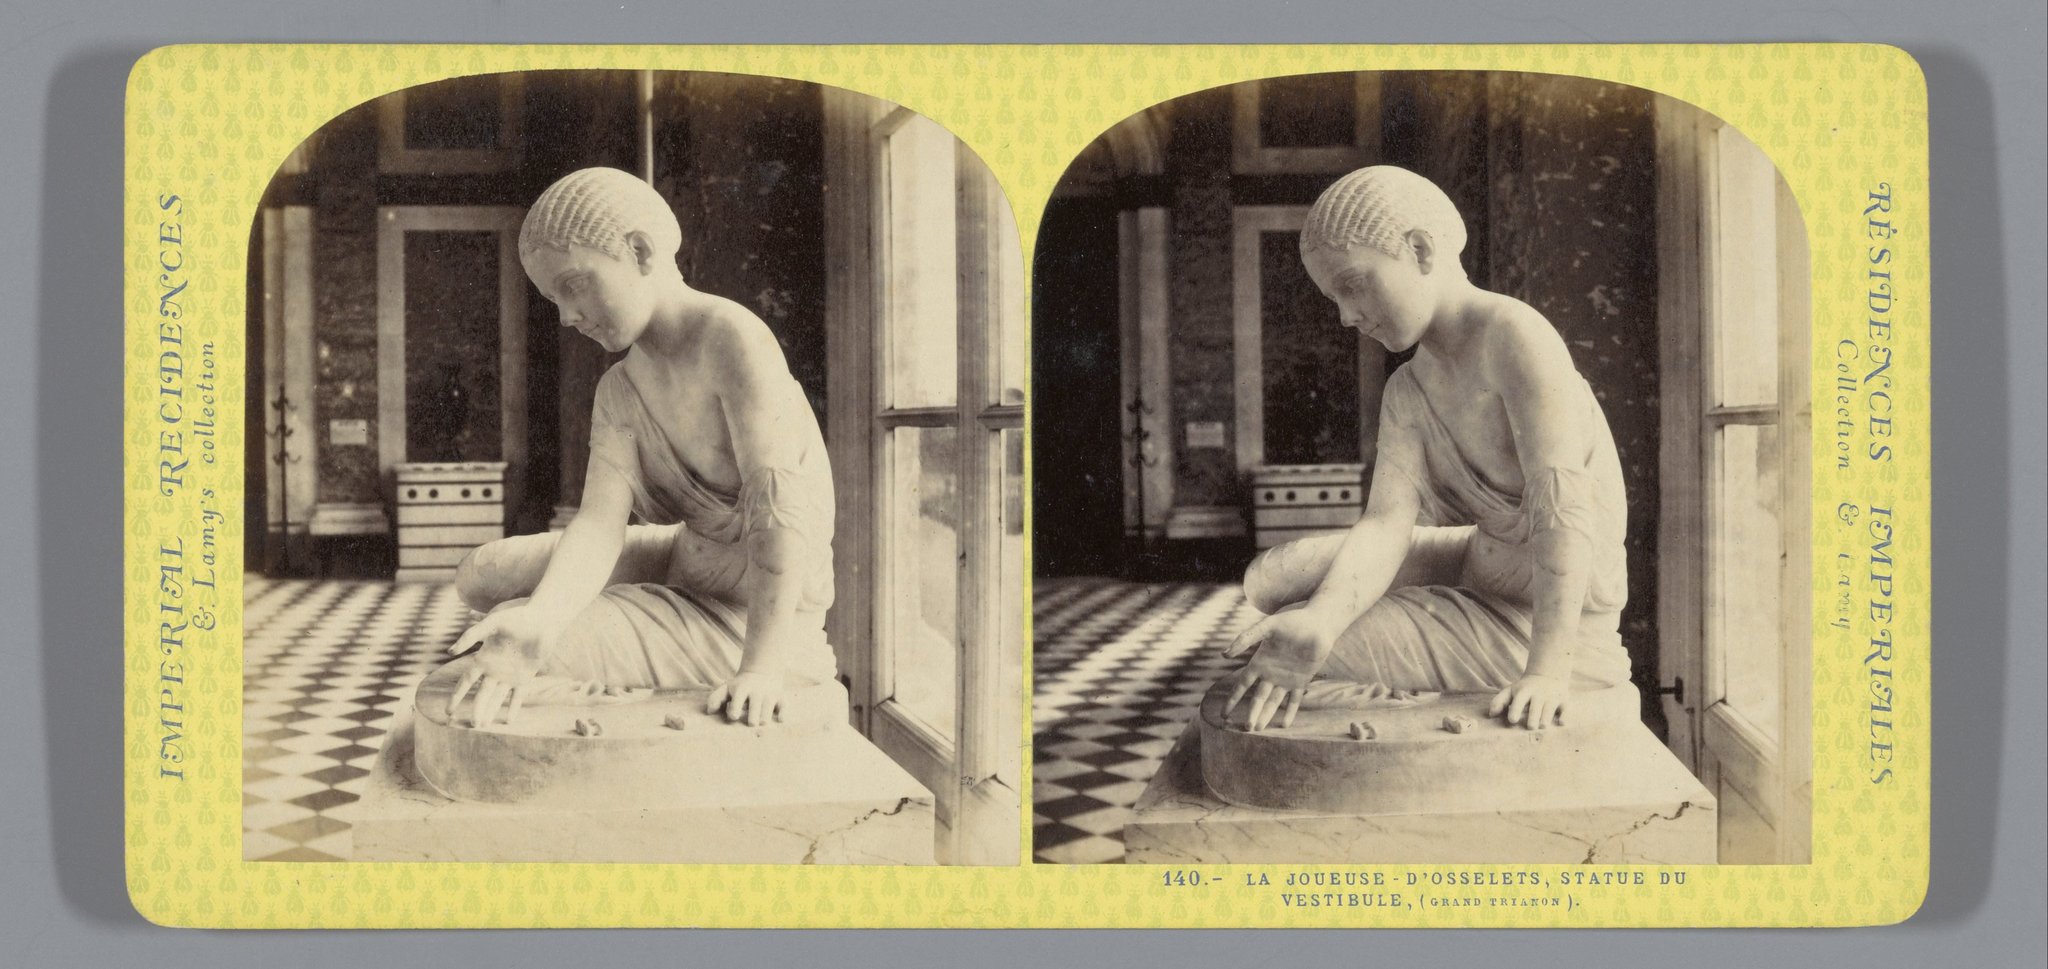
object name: stereograph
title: La joueuse-d'osselets, statue du vestibule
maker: ernest eléonor pierre lamy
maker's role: publisher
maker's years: 1828-1900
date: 1860-1880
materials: cardboard, photographic support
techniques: albumen print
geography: grand trianon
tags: vestibule, hall, sculpture, (playing at) knuckle-bones, 'astragali'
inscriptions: number: ‘140.’, inscription: ‘E. Lamy's collection’